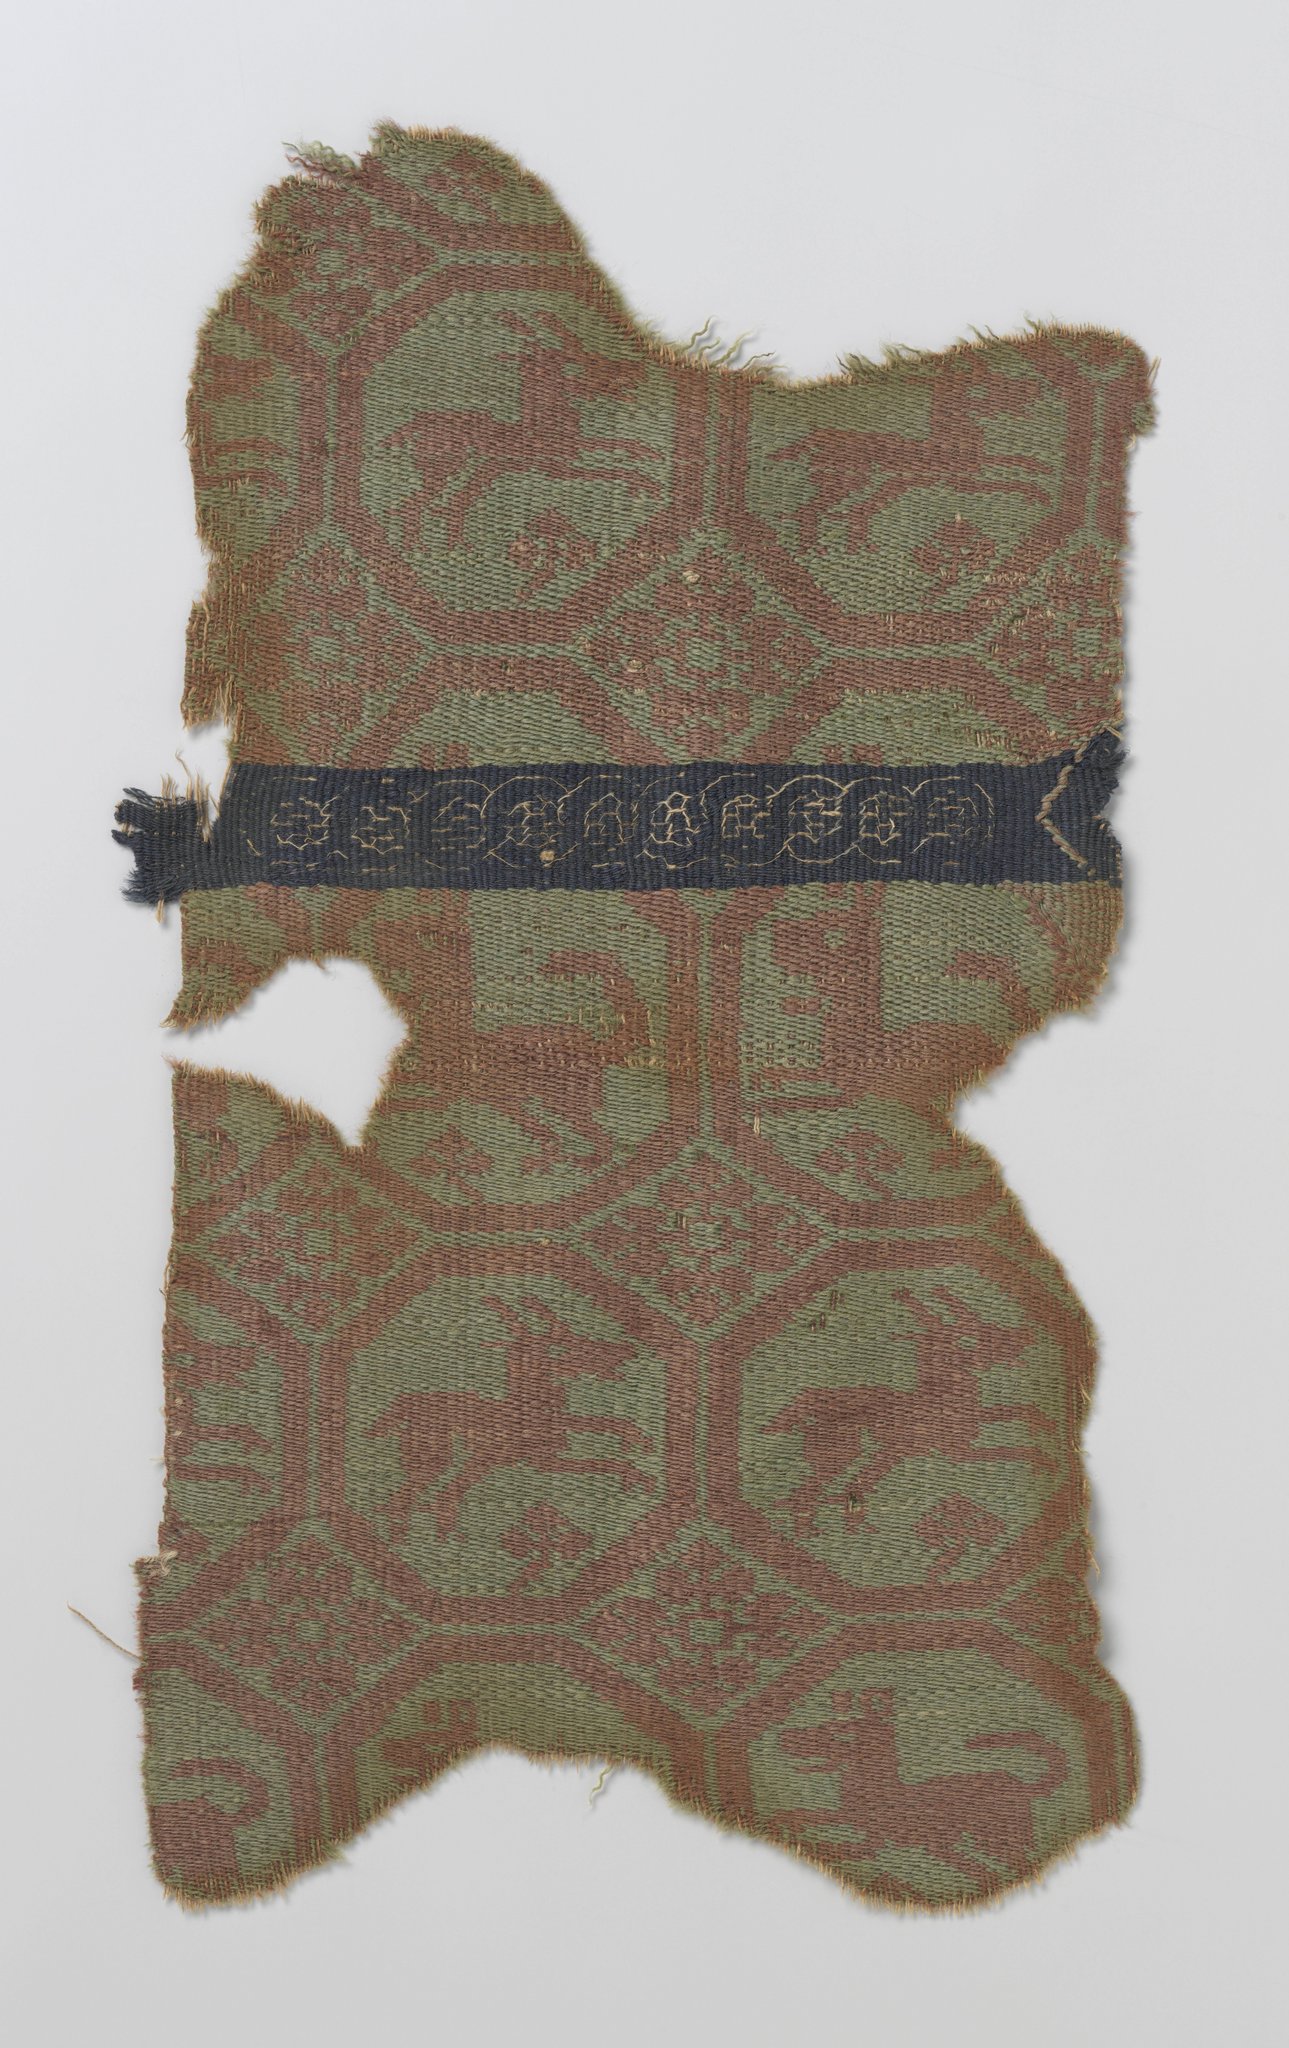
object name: fragment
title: Fragment samiet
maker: Anonymous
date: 400-599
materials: linen, wool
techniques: samite, tapestry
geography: egypt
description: Weefselfragment met een rood patroon op groen grond, bestaande uit achthoeken, afwisselend gevuld met een naar rechts springend hert of een naar links lopende hond. Tussen de achthoeken een gestileerd bloemmotief. Het patroon wordt onderbroken door een horizontal band van donkerblauw met in vliegende draadtechniek een aaneengeschakeld cirkelmotief.